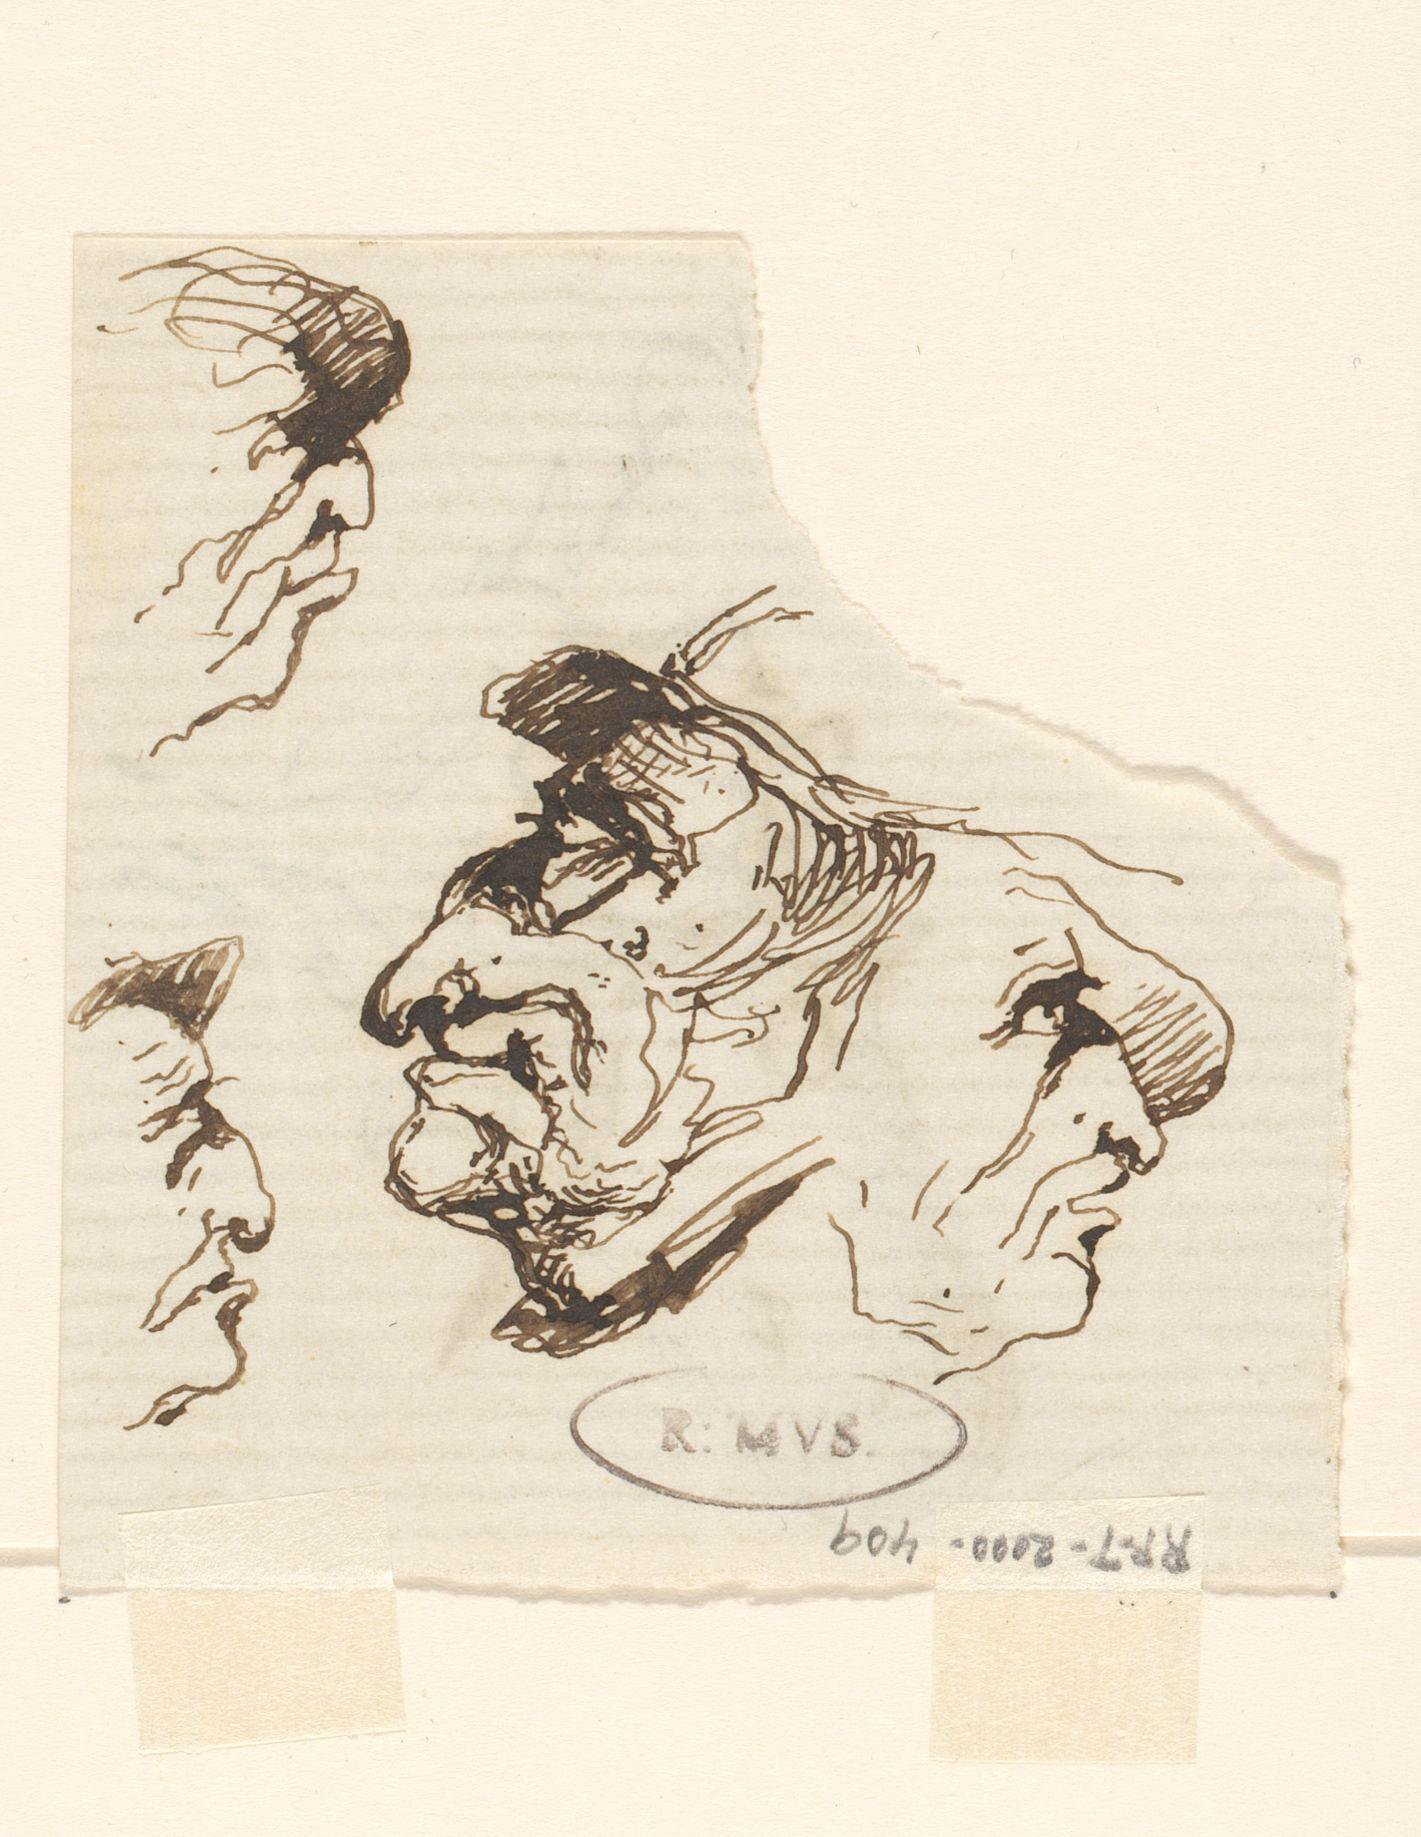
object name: drawing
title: Vier koppen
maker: johannes tavenraat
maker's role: draughtsman, painter, print maker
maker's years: 1809-1881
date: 1840-1880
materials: ink, paper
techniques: pen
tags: caricatures (human types)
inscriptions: collector's mark: Lugt 2228